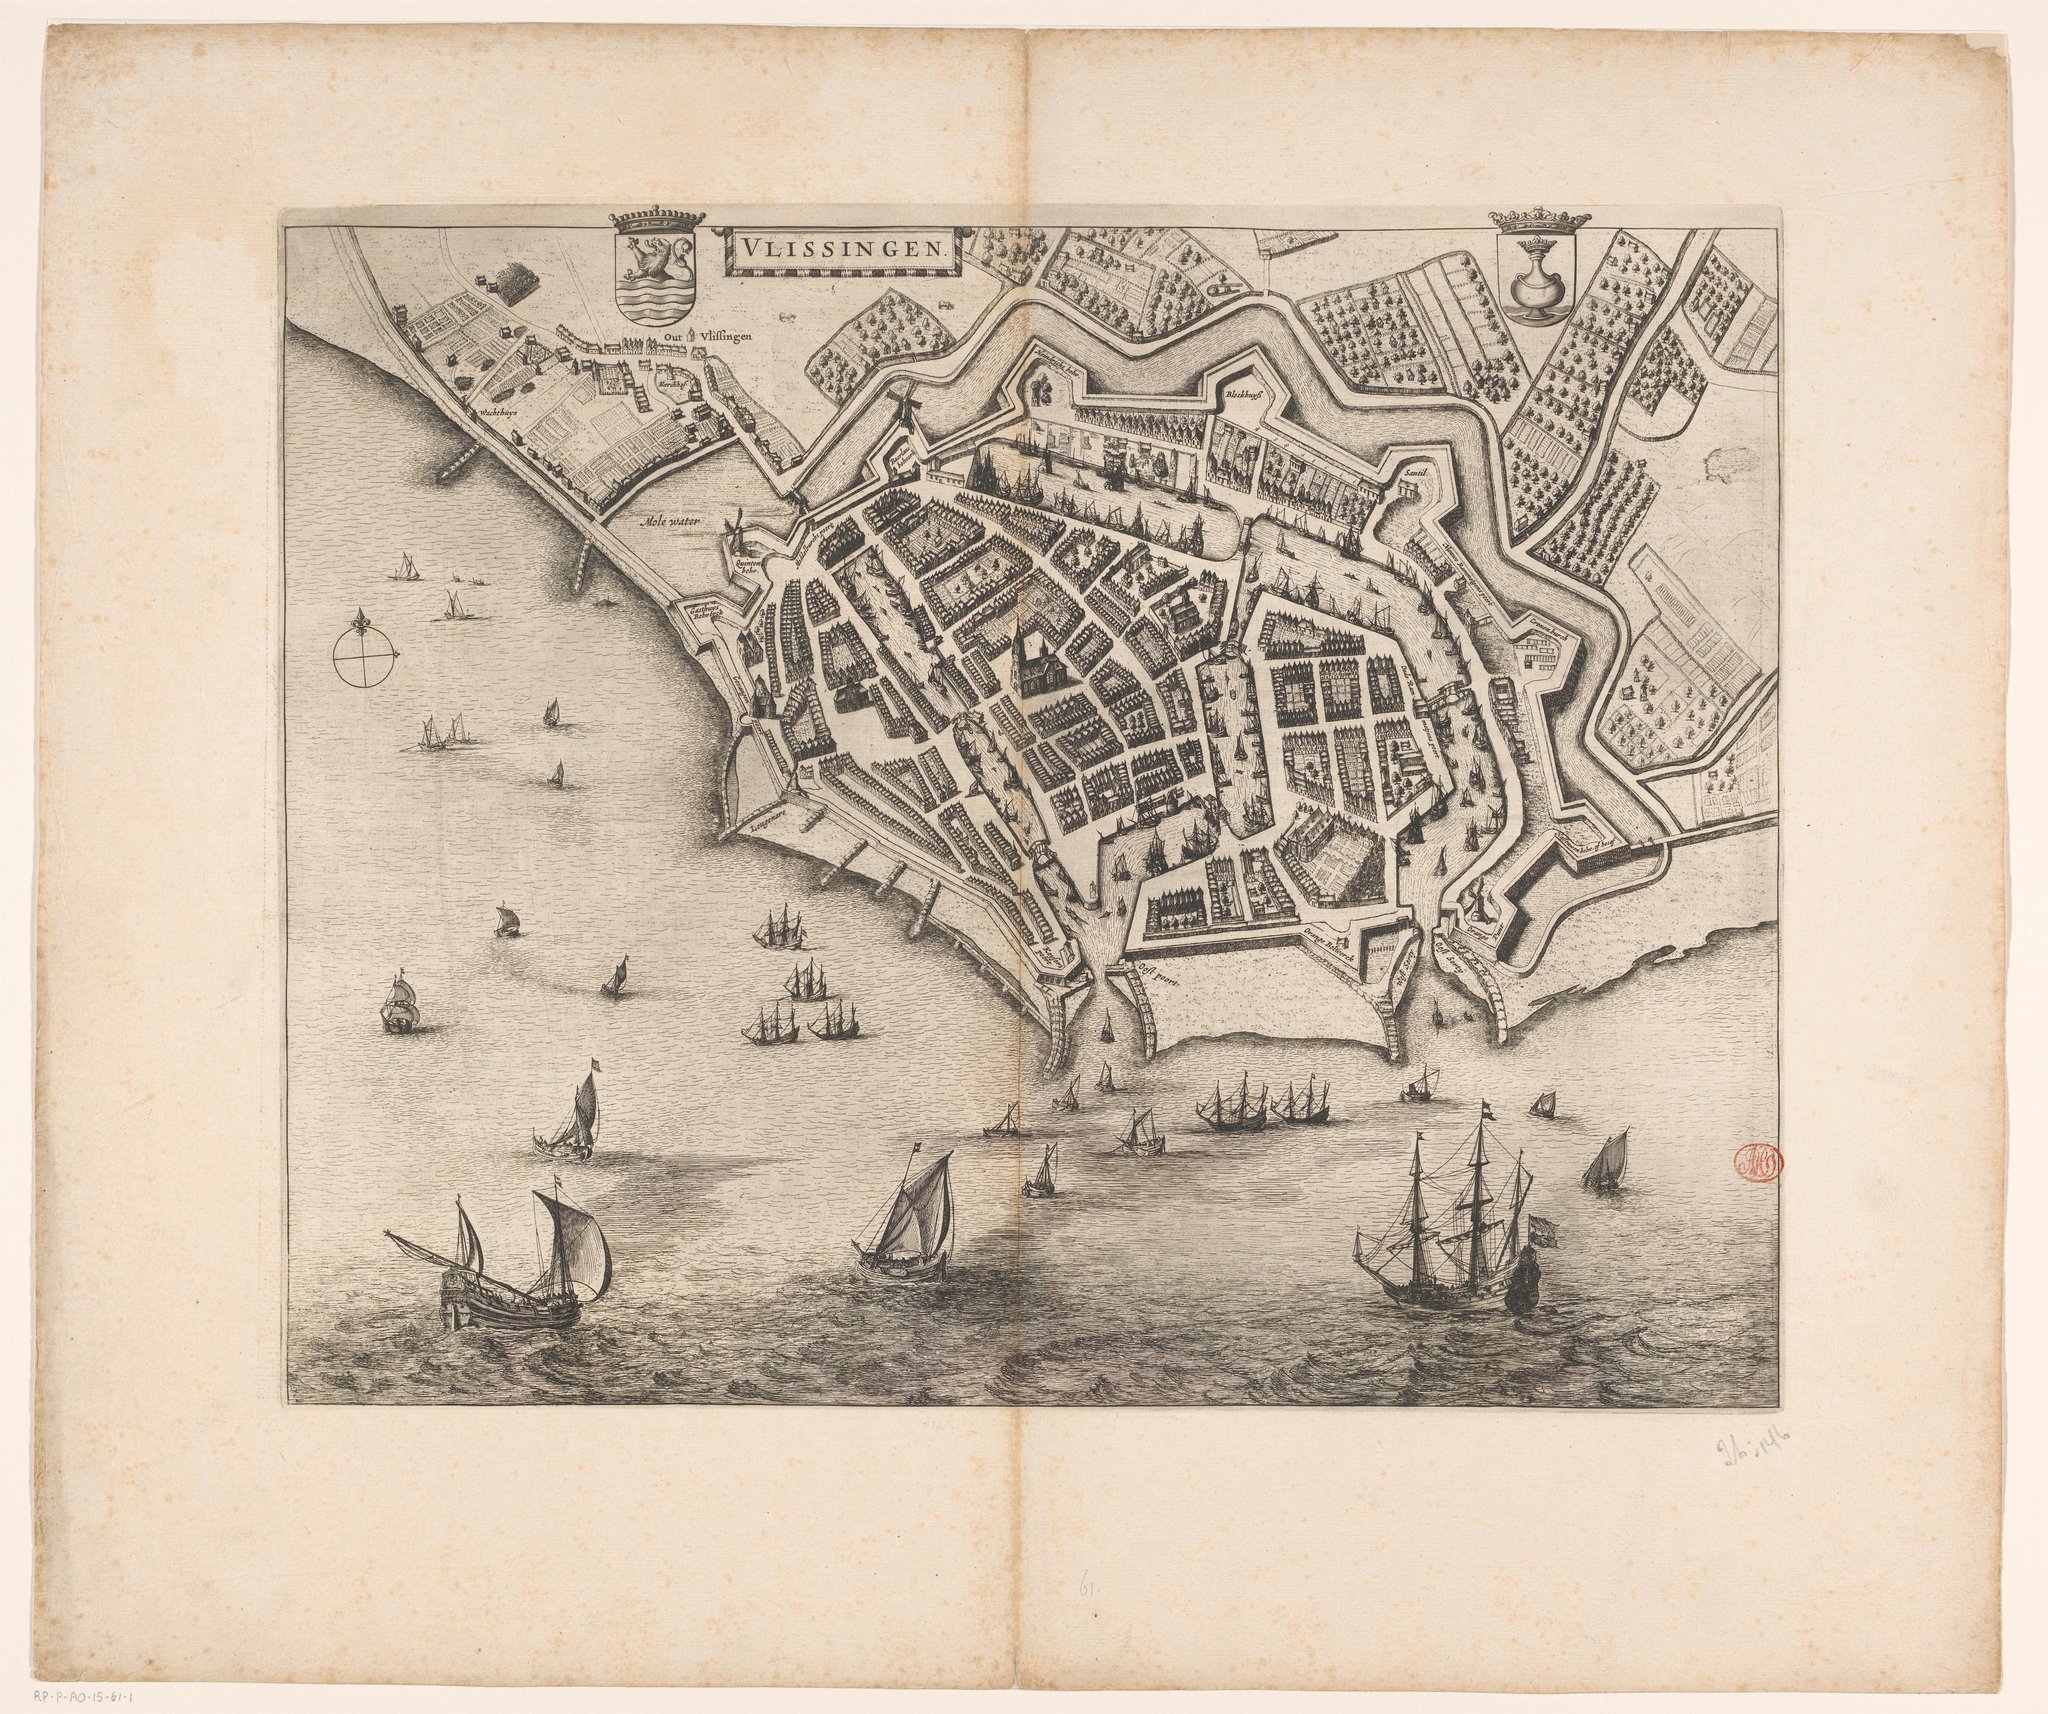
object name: print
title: Vlissingen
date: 1652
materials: paper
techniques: engraving, etching, letterpress printing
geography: amsterdam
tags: coat of arms (as symbol of the state, etc.) (+ city; municipal), maps of cities, coat of arms (as symbol of the state, etc.) (+ province; provincial), flushing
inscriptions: collector's mark: Lugt 195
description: Plattegrond in vogelvluchtperspectief. Linksboven het wapen van Zeeland met rechts daarvan de titel. Rechtsboven het wapen van Vlissingen. Op verso Nederlandse tekst.